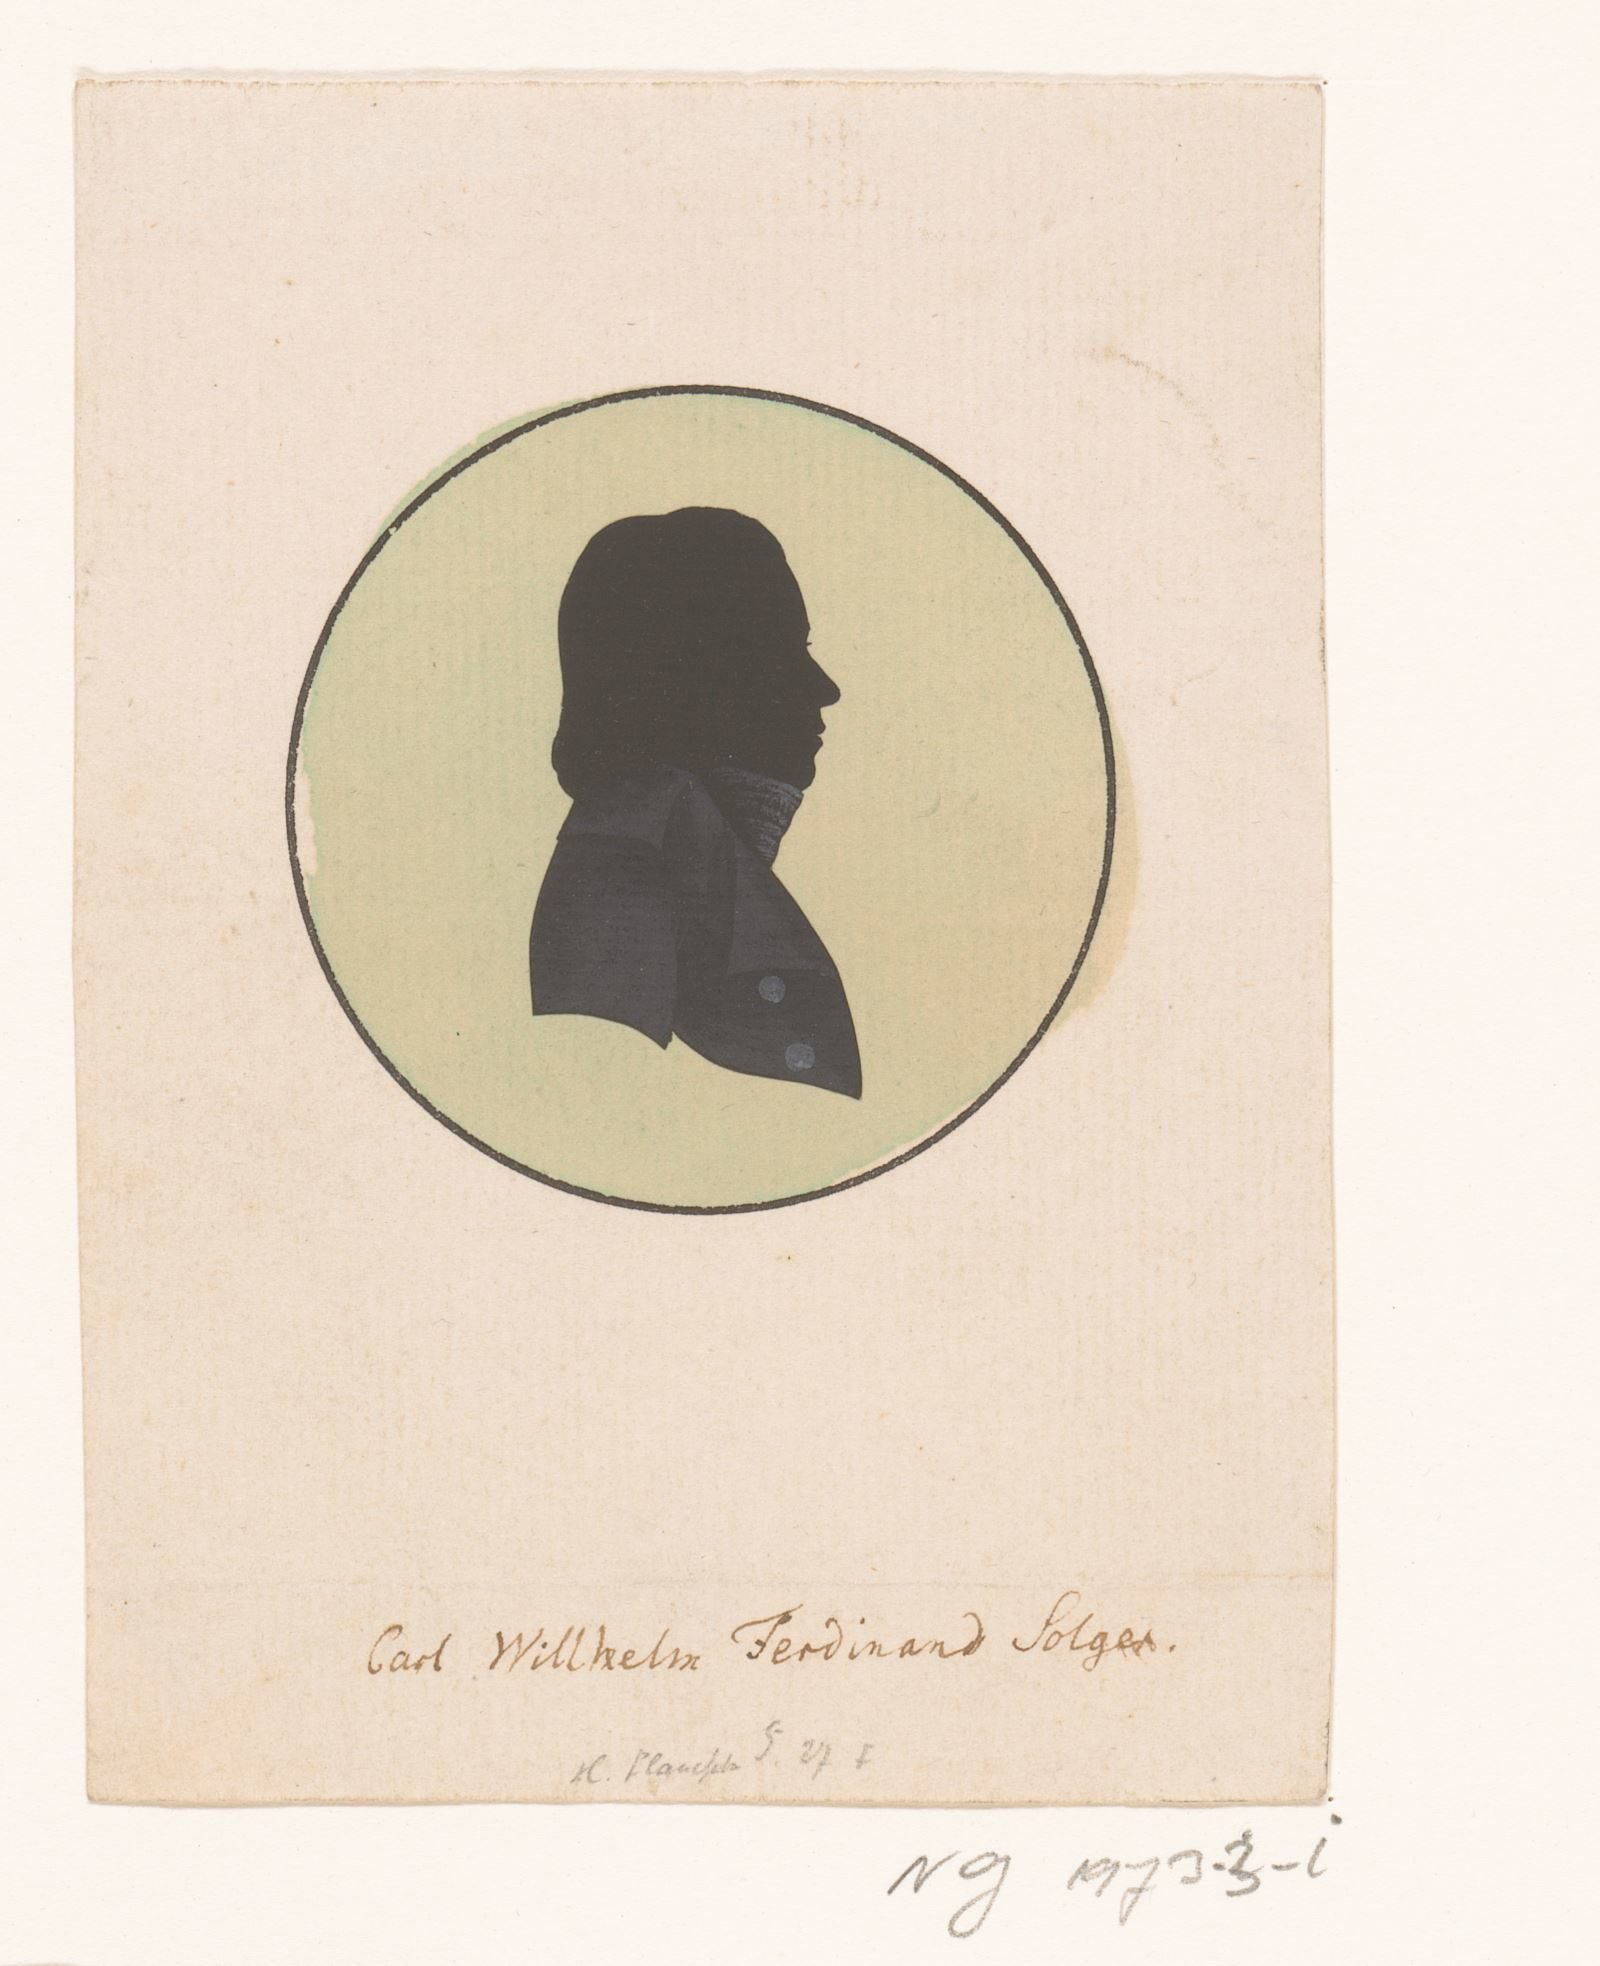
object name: drawing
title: Tekening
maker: Anonymous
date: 1800-1819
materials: ink, paper, watercolor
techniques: drawing, snipping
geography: germany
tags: the hague, johan rudolf thorbecke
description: Silhouet van een man (kop en schouders) naar rechts, geplakt op een met groene waterverf ingekleurde medaillon. Opschrift; m.o.: Carl Wilhelm Ferdinand Solger.